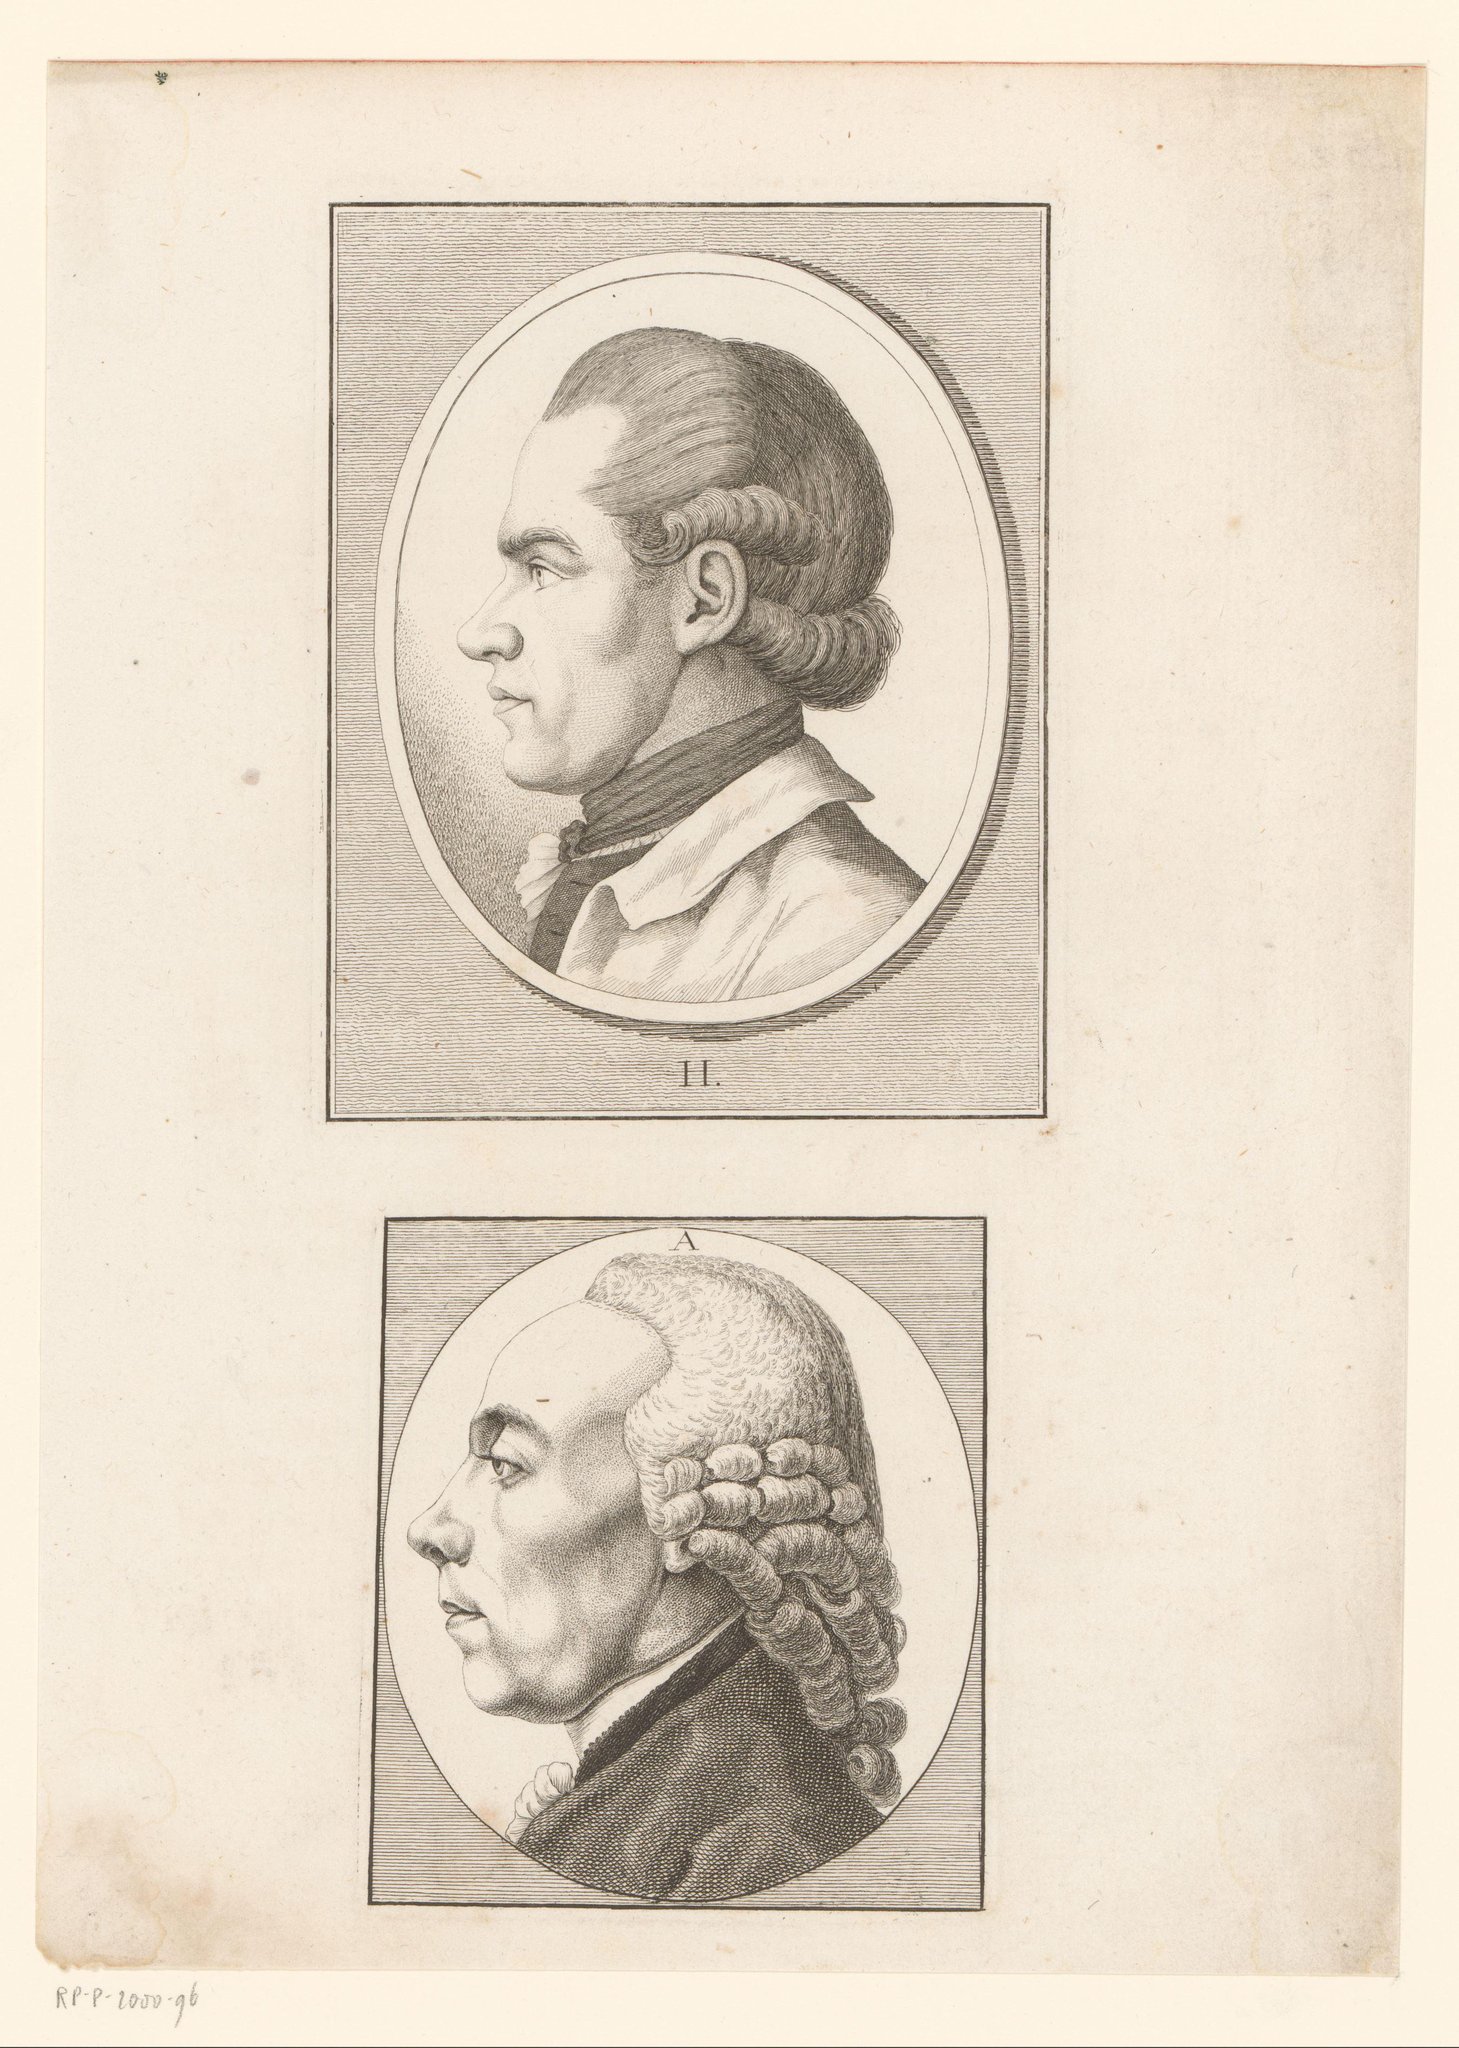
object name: print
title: Twee mannenkoppen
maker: Anonymous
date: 1700-1799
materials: paper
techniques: engraving, etching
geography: germany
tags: silhouette-apparatus, 'physionotrace'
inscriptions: collector's mark: Lugt 2760, collector's mark: Lugt 2228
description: De portretten komen van afzonderlijke platen.